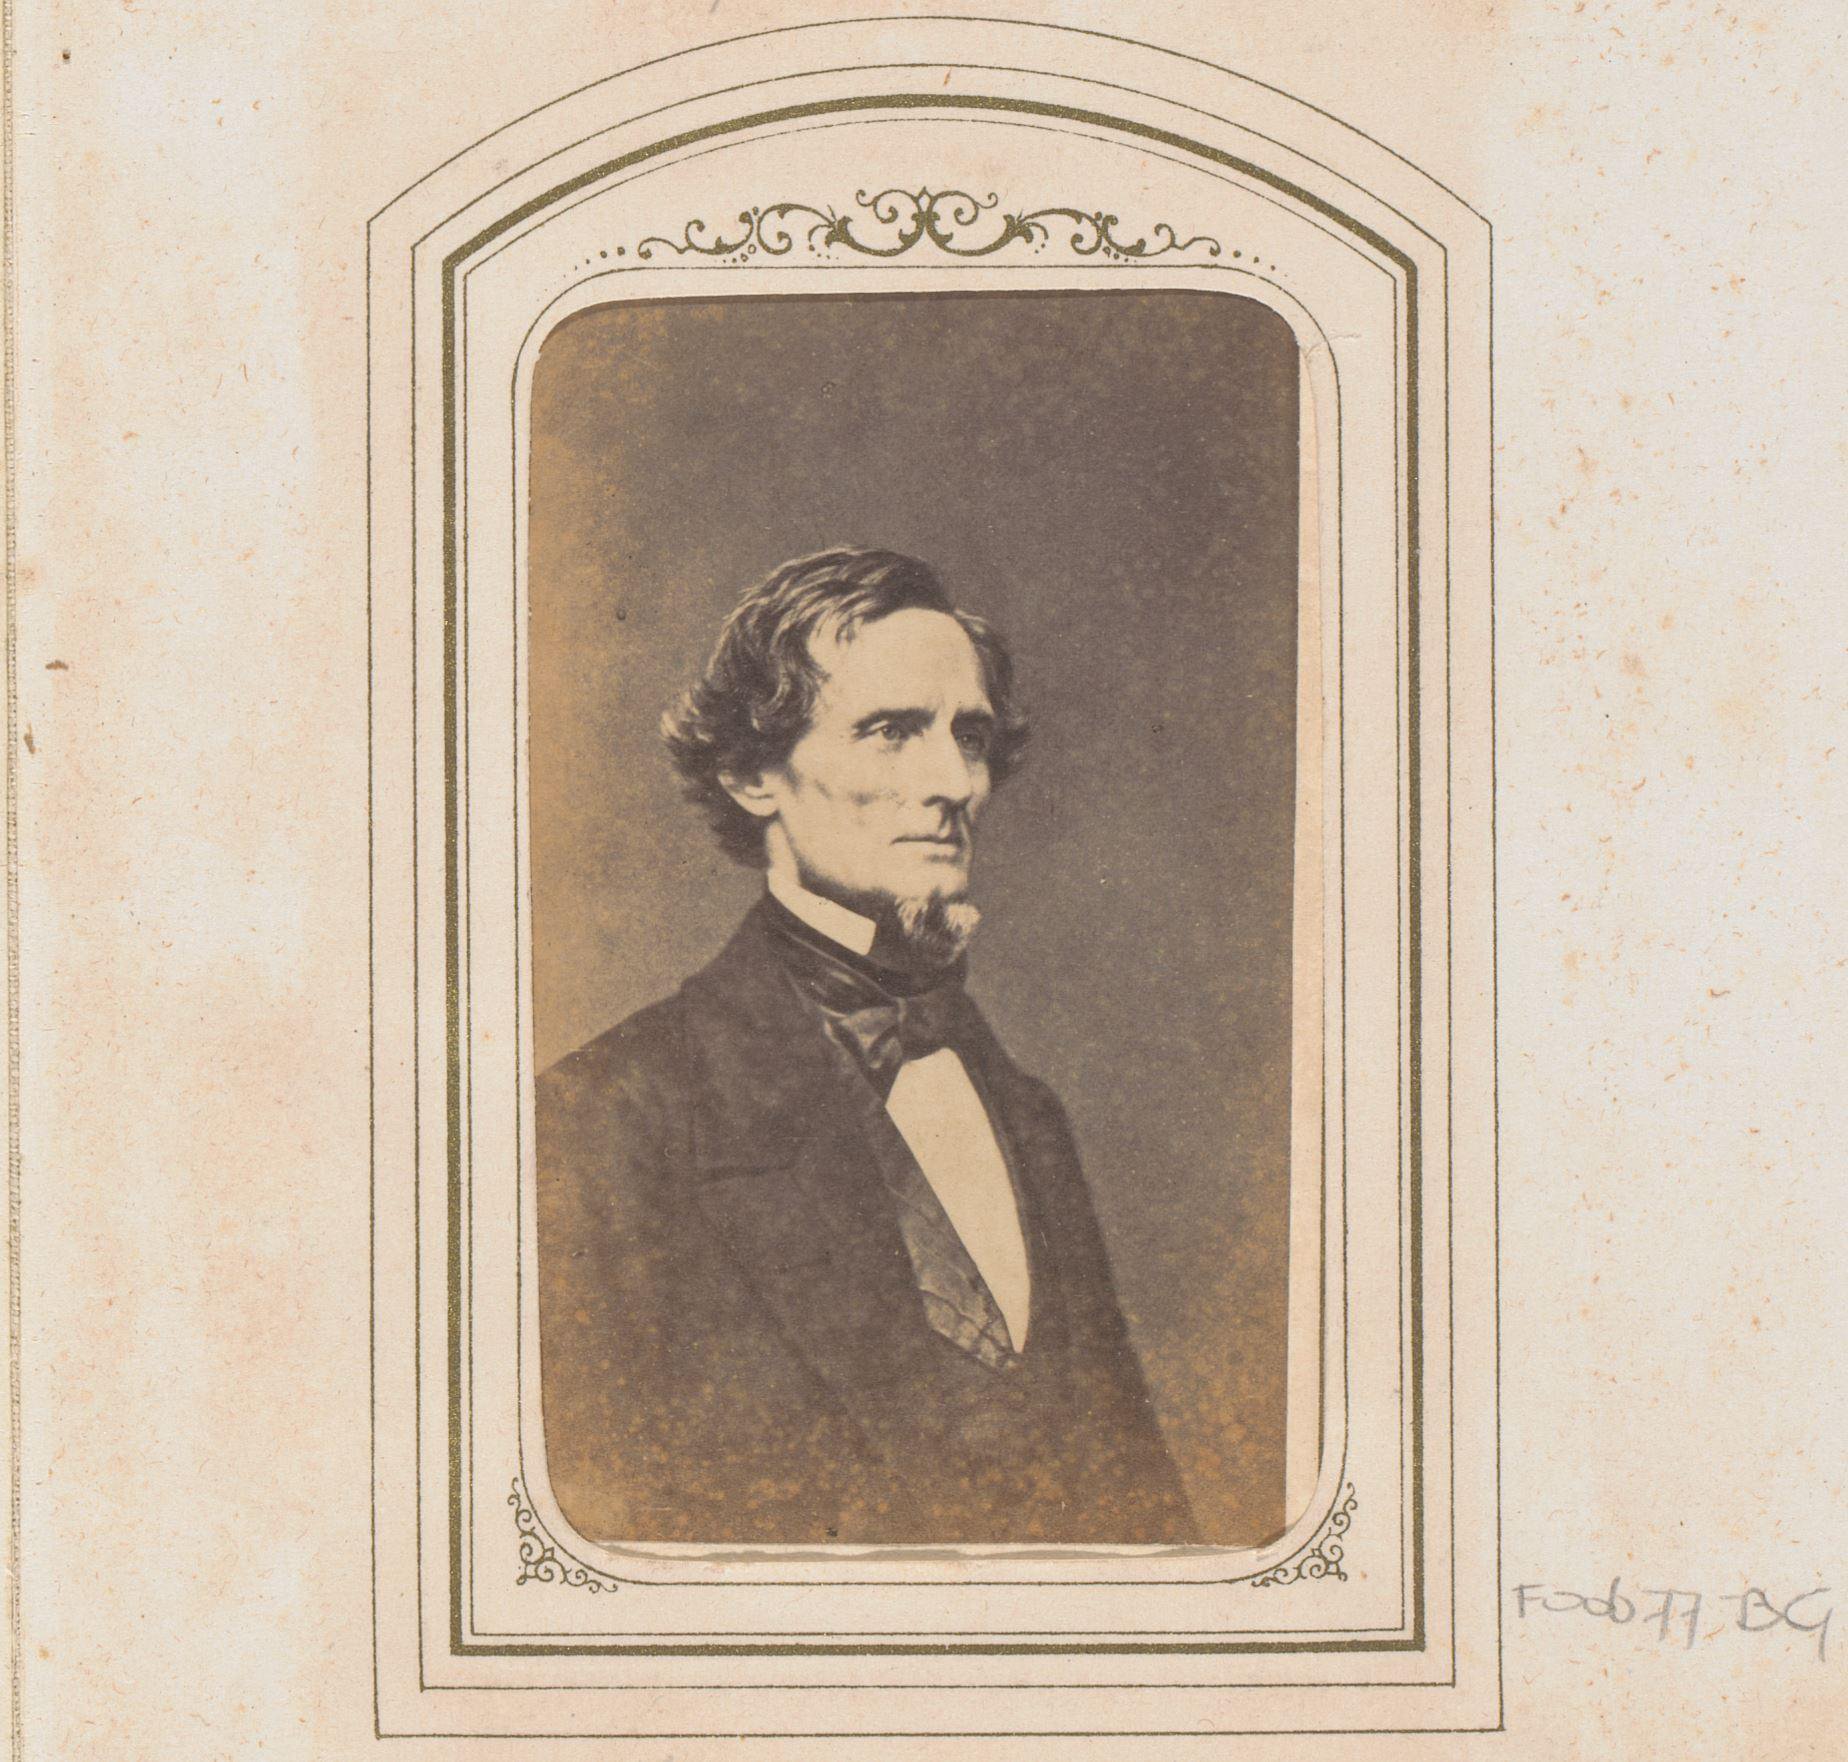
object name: carte de visite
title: Portret van Jefferson Davis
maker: mathew benjamin brady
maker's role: fotograaf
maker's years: 1823-1896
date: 1855-1870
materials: cardboard, photographic support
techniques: albumen print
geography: new york city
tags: historical persons, politician, e.g. party leader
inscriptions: number: ‘8’, name: ‘Jefferson Davis’, inscription: ‘Published by/ E&H.T. ANTHONY/ 501 Broadway./ New York./ FROM/ PHOTOGRAPHIC NEGATIVE/ in/ BRADY'S/ National Portrait Gallery’, annotation: ‘Jefferson Davis 1808/89/ Pres. Z-Am Staten/ (foto Brady)’